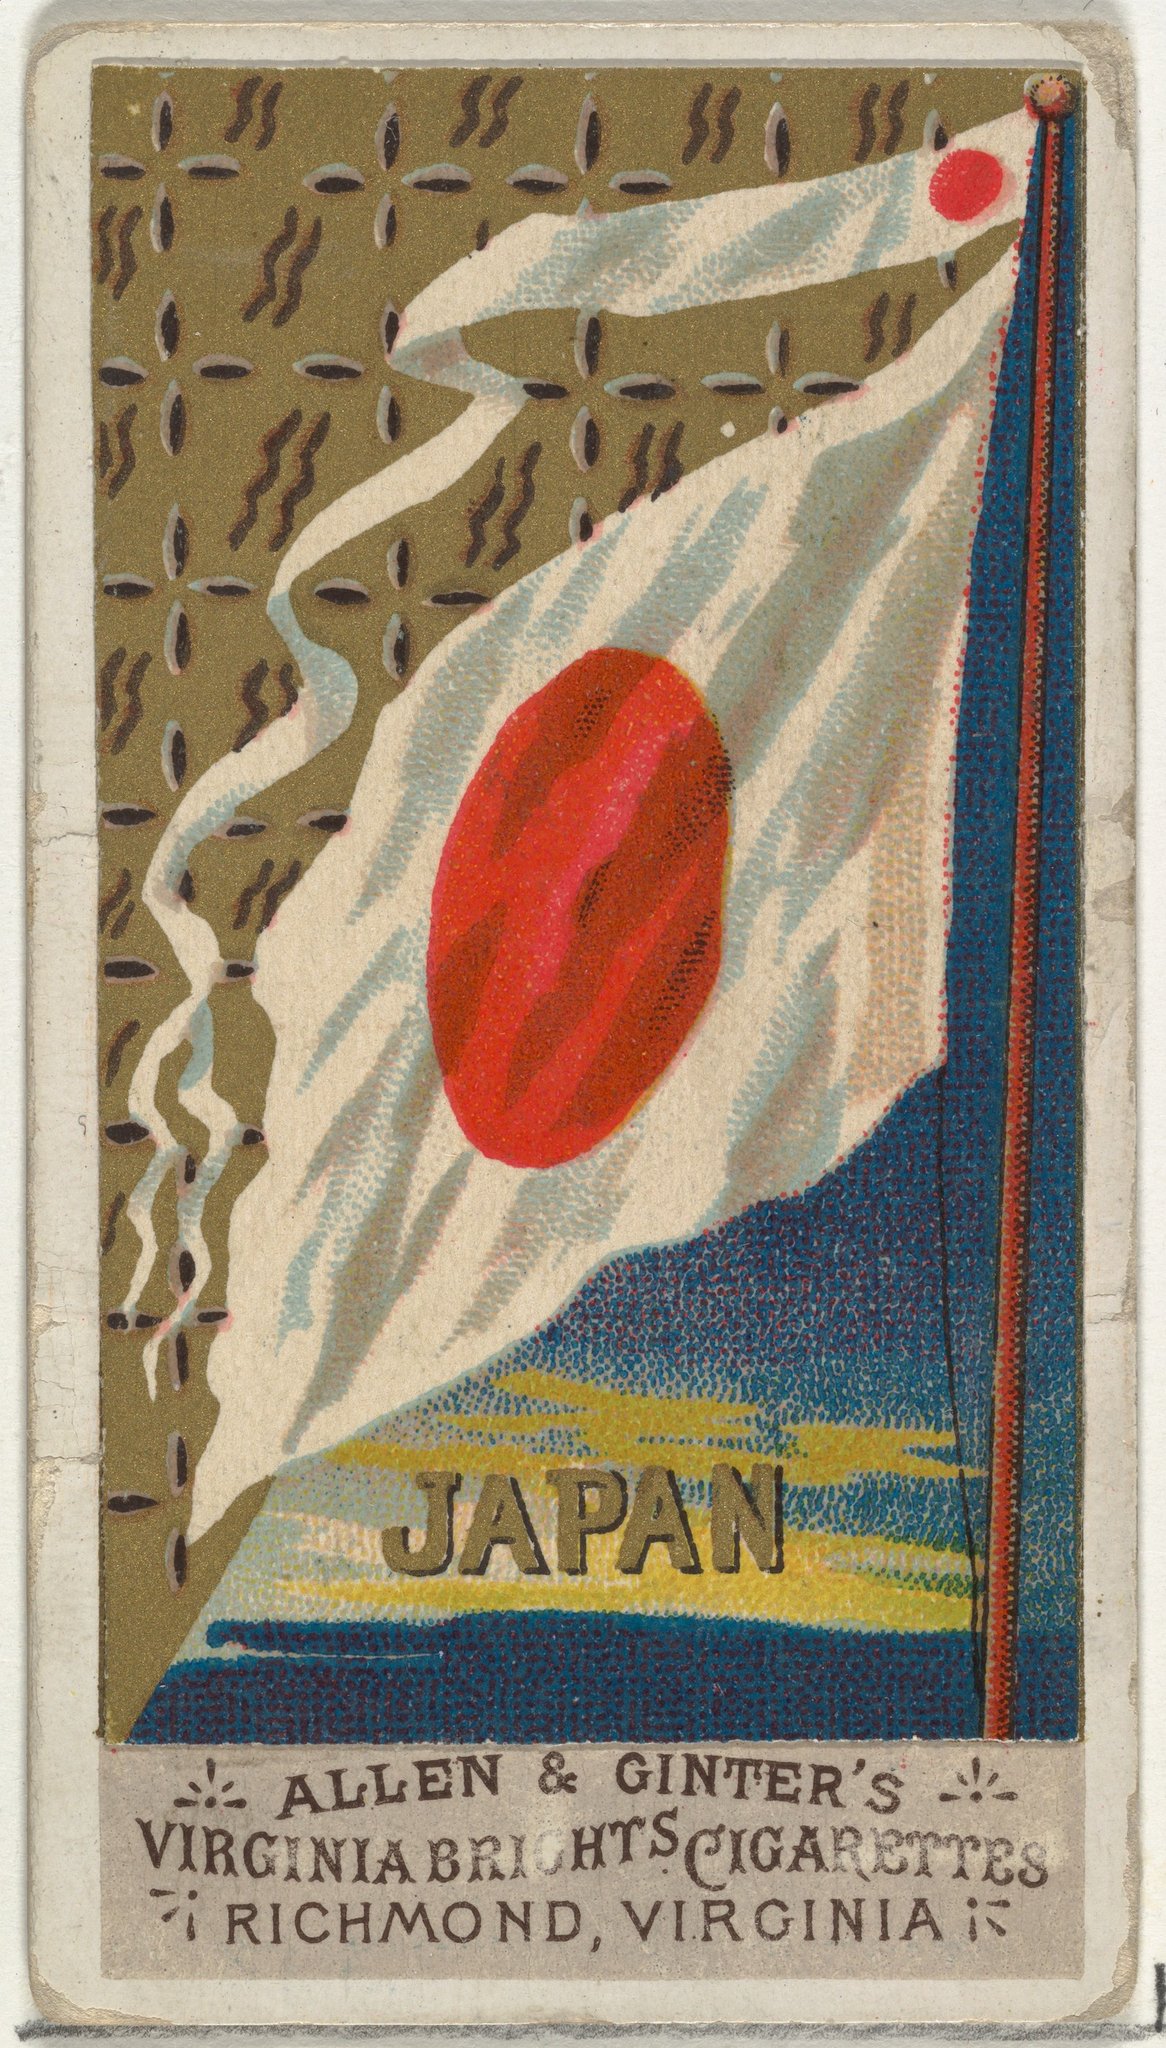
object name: print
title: Japan, from Flags of All Nations, Series 1 (N9) for Allen & Ginter Cigarettes Brands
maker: allen & ginter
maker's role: publisher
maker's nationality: american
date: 1887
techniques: color lithograph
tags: flags